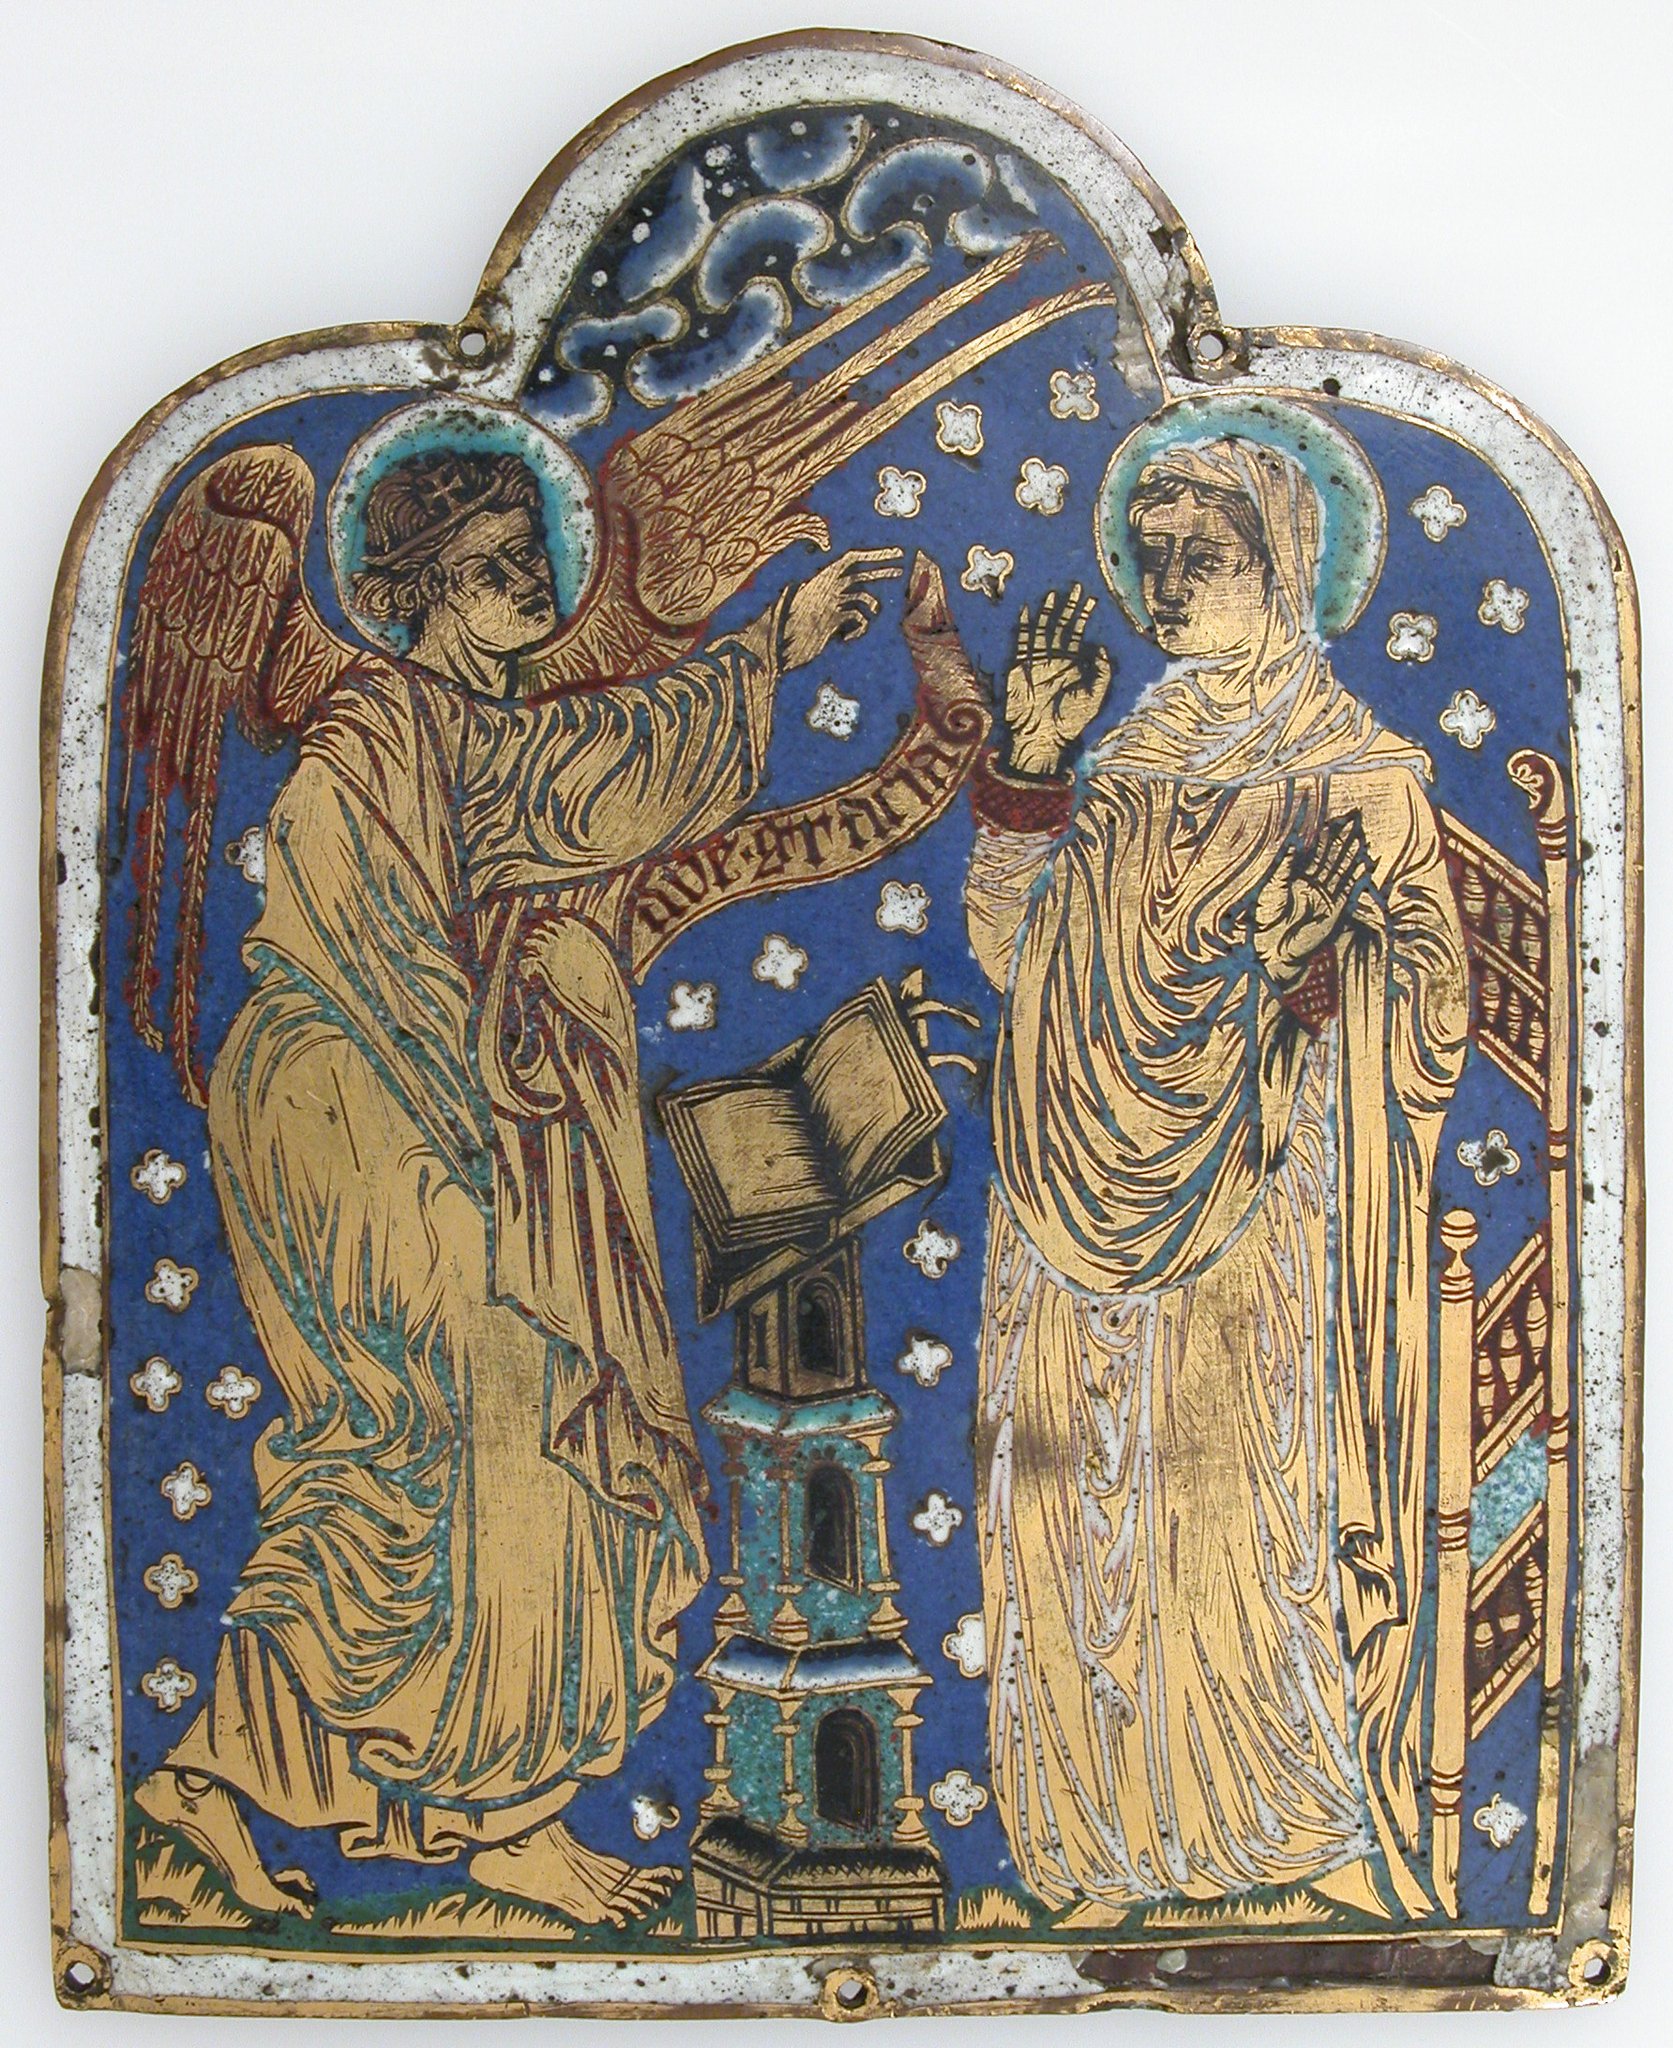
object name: plaque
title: Plaque with The Annunciation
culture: german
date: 1826-1850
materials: gilt copper, enamel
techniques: enamel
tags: angels,virgin mary